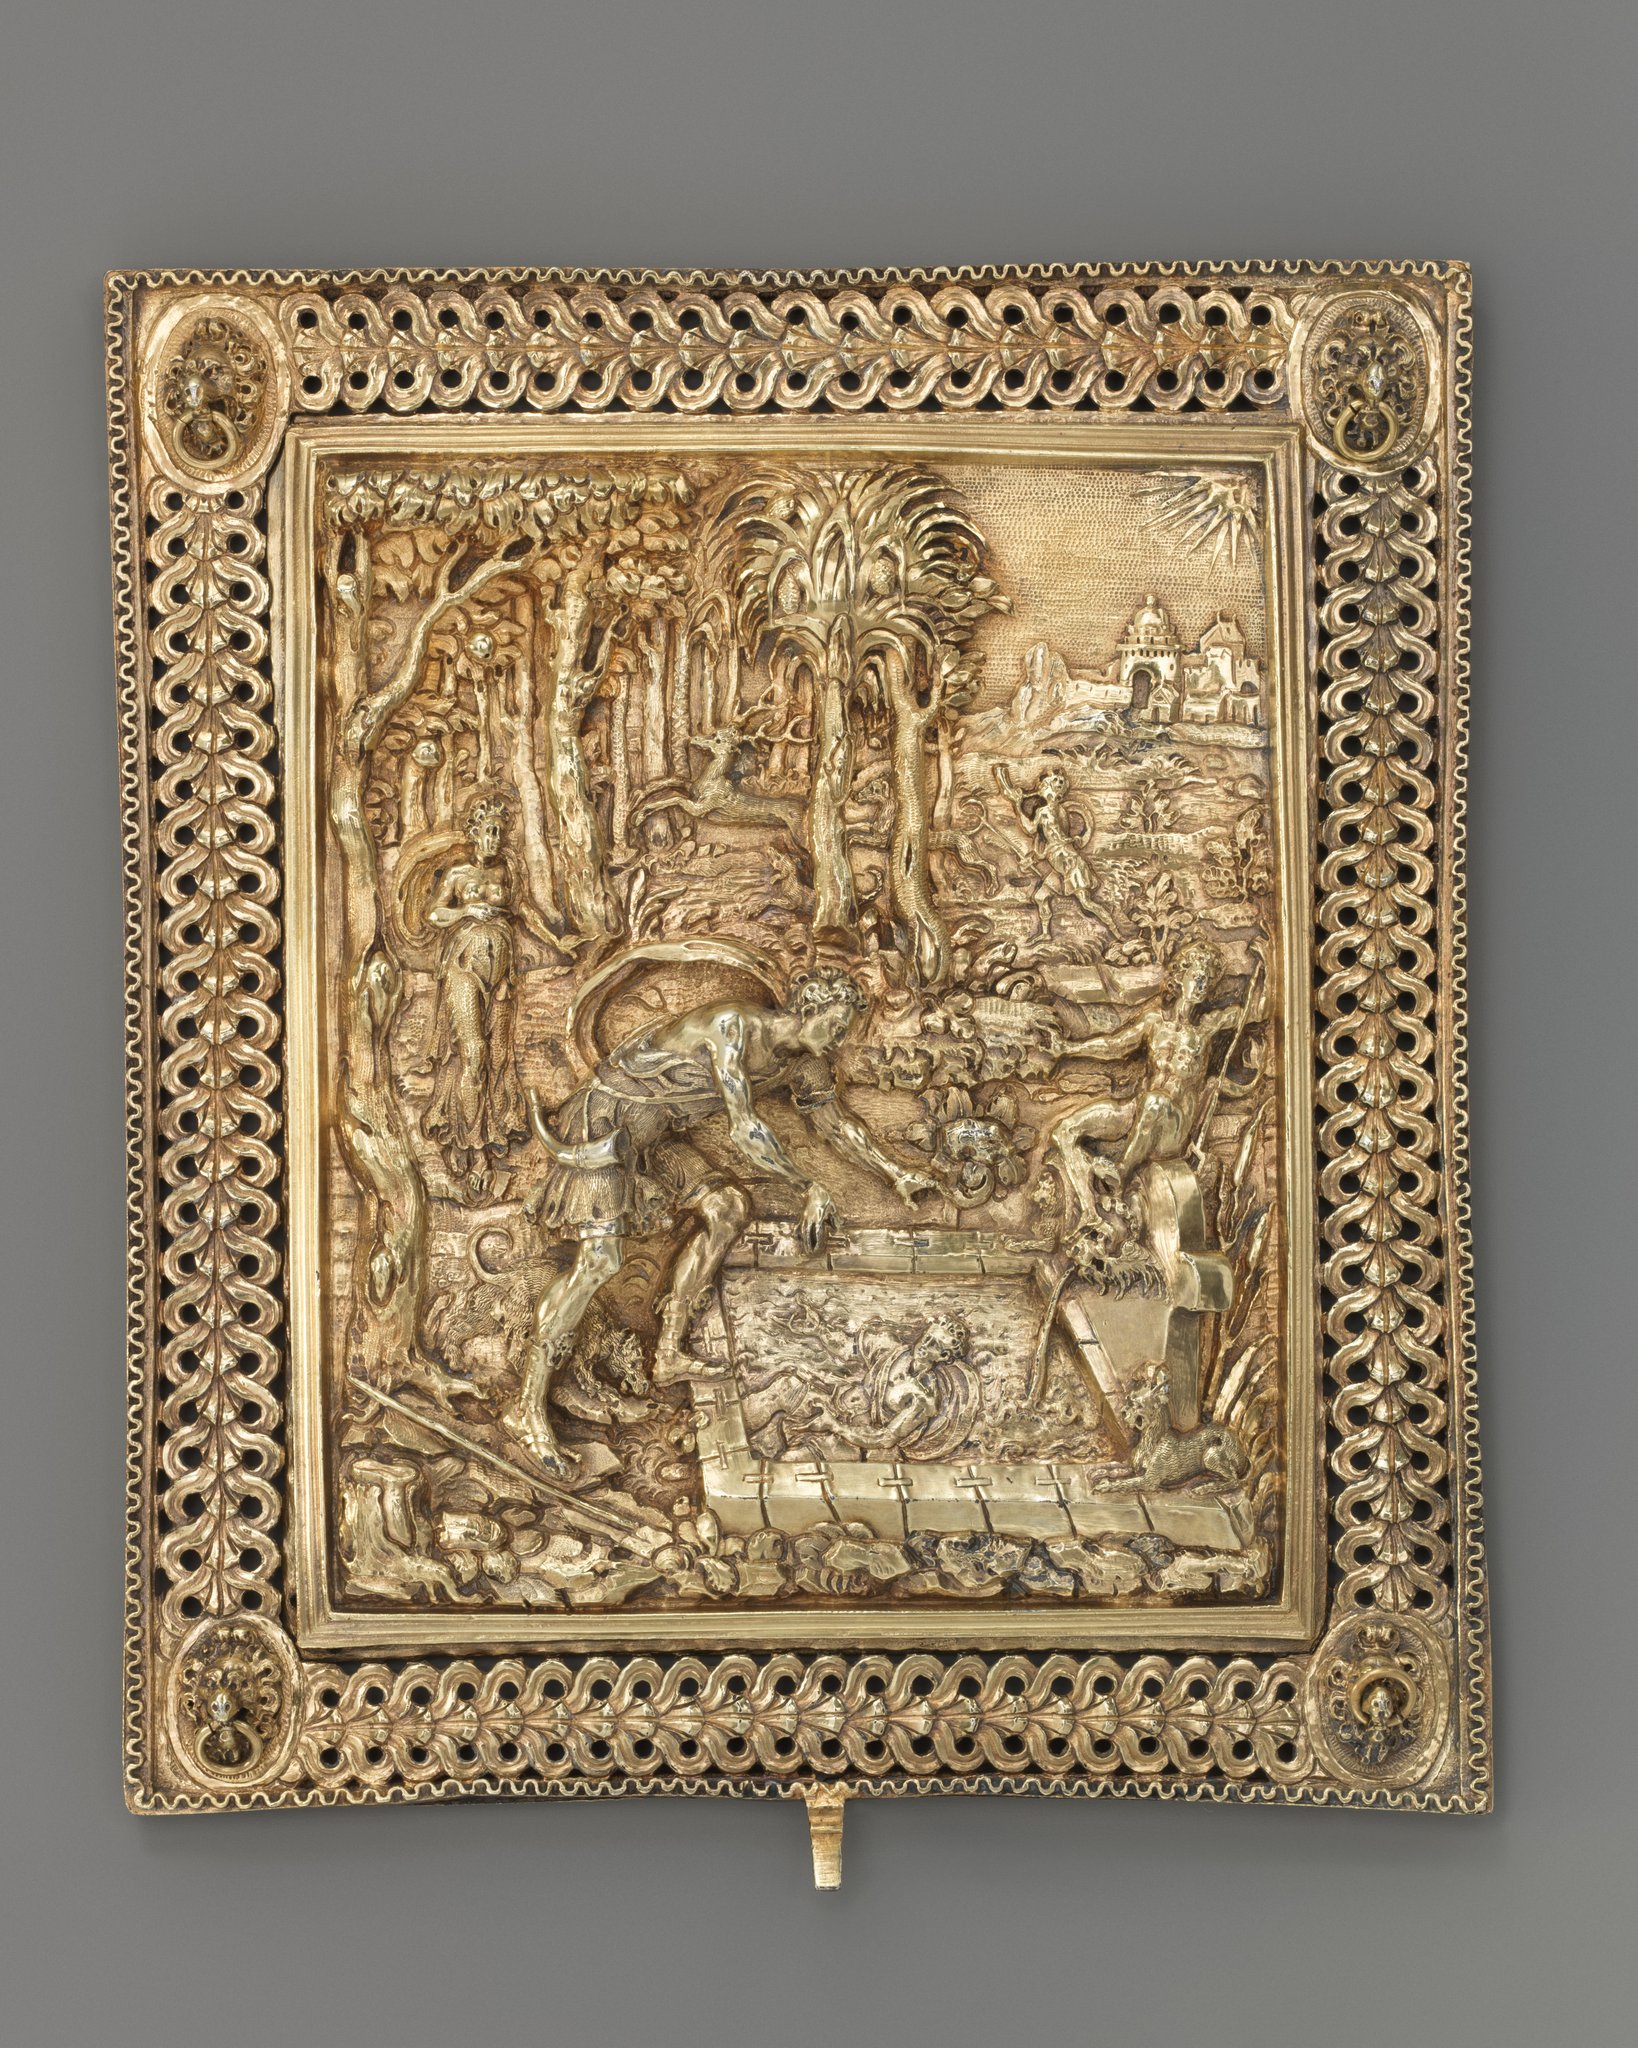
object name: relief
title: Narcissus at the Source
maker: christoph jamnitzer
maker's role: artist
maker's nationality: german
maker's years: 1563-1618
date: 1600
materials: gilt silver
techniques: casting, chasing, engraving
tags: narcissus